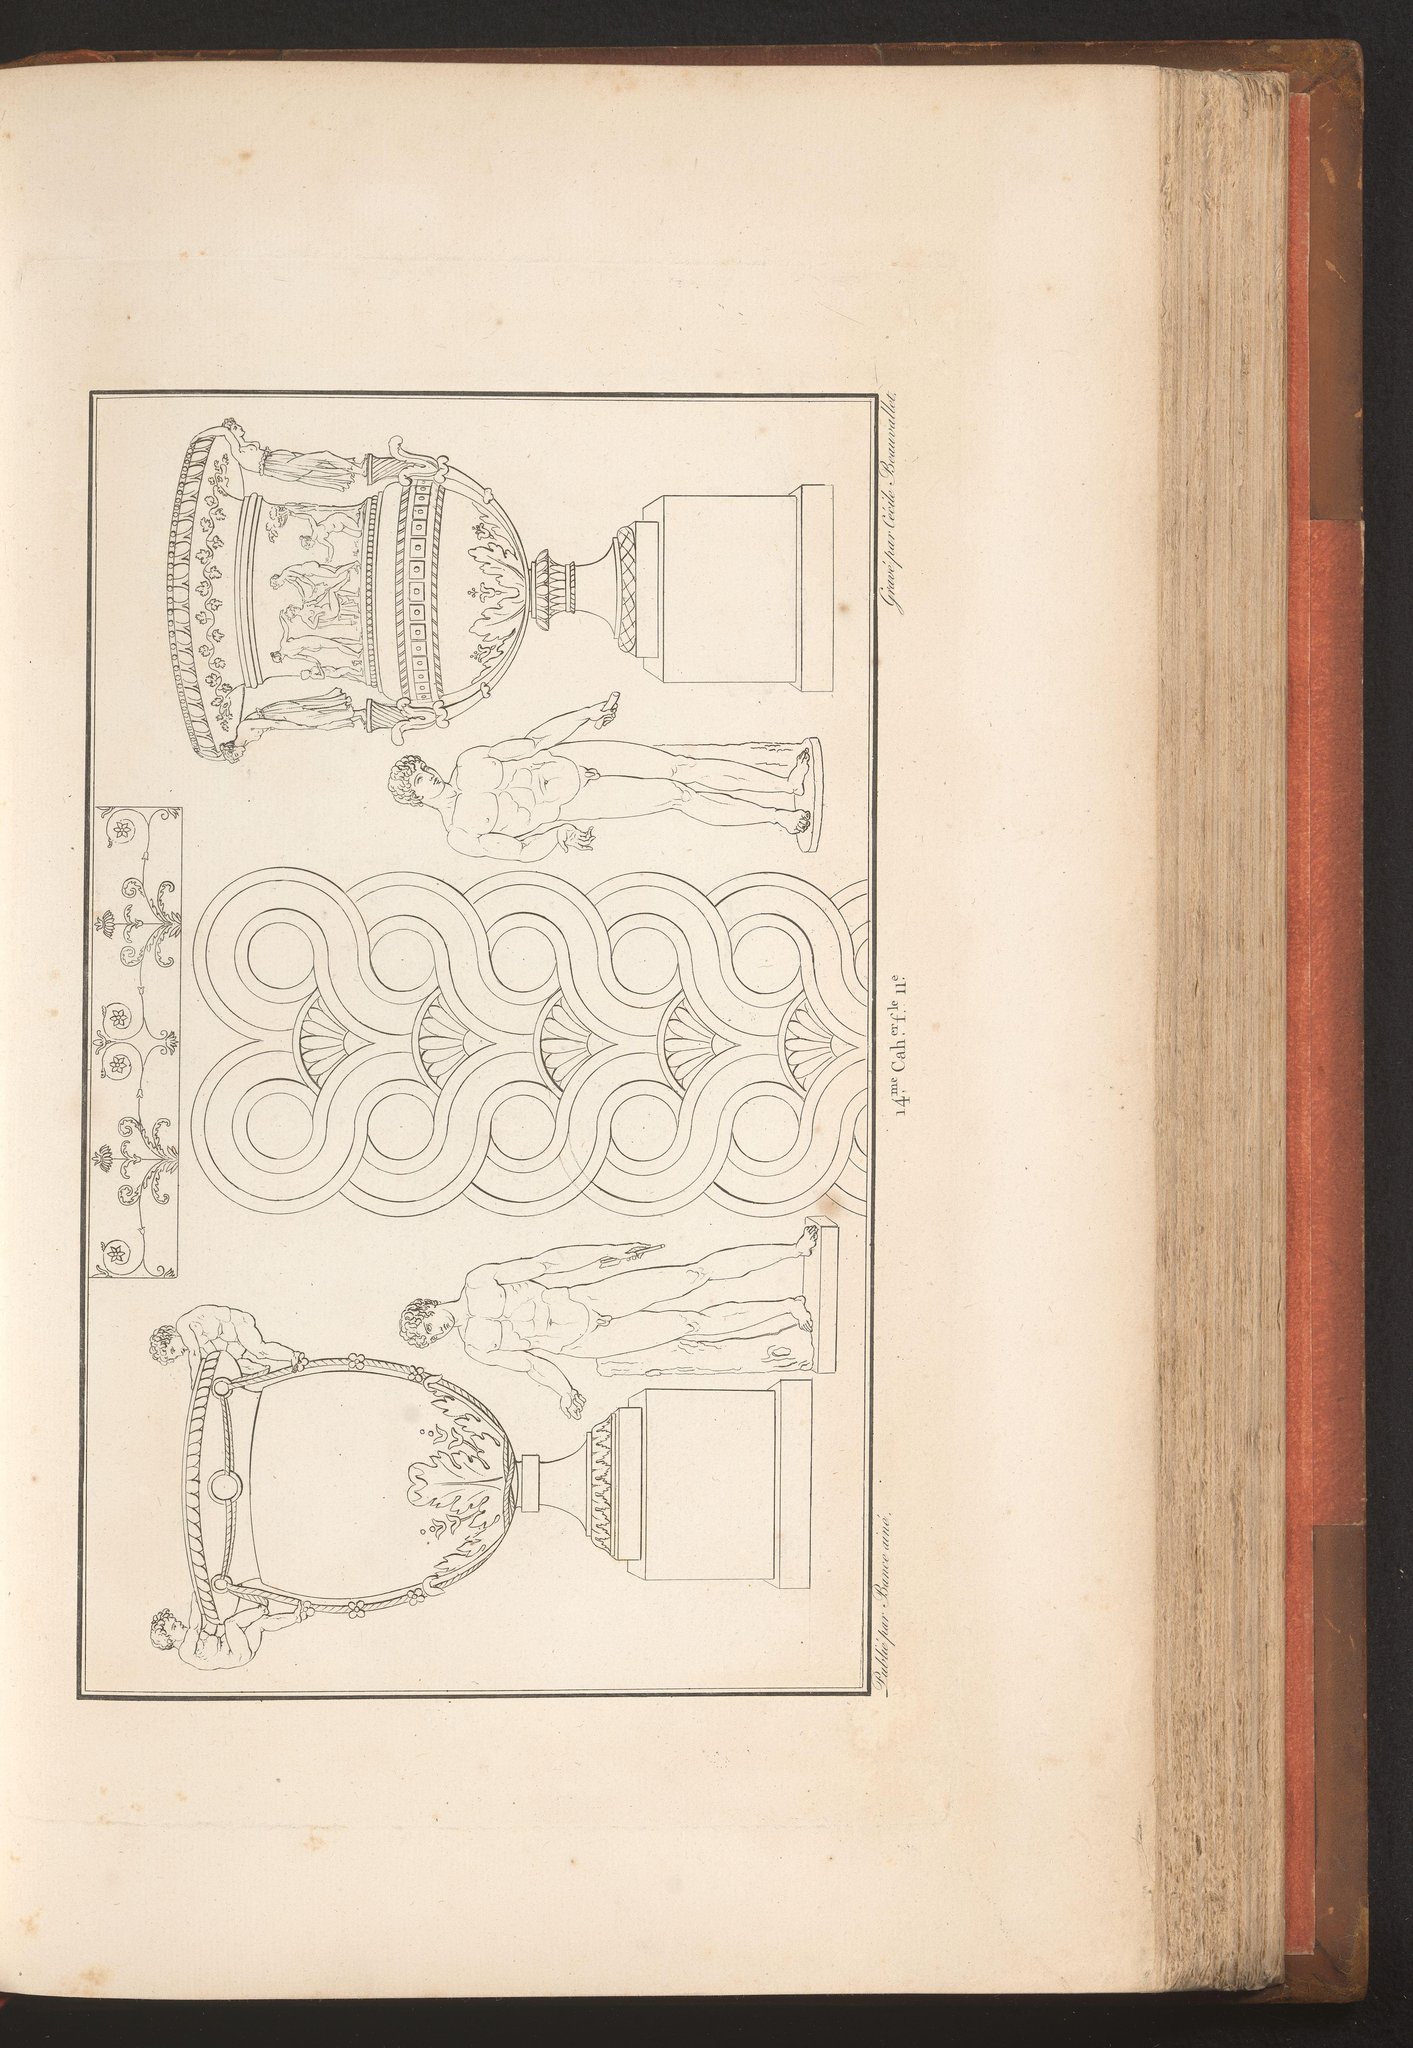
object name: ornament print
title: Diverse ornamenten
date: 1820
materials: paper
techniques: etching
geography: paris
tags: vase ~ ornament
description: Ornamentprent met twee vazen en staande figuren aan weerszijden van een centraal ornament. Onderdeel (14e. Cah. f.le 11) van het prentalbum met twee series van in totaal 138 ornamentprenten door Beauvallet en Normand, 'Fragmens d'Ornemens dans le Style Antique'.